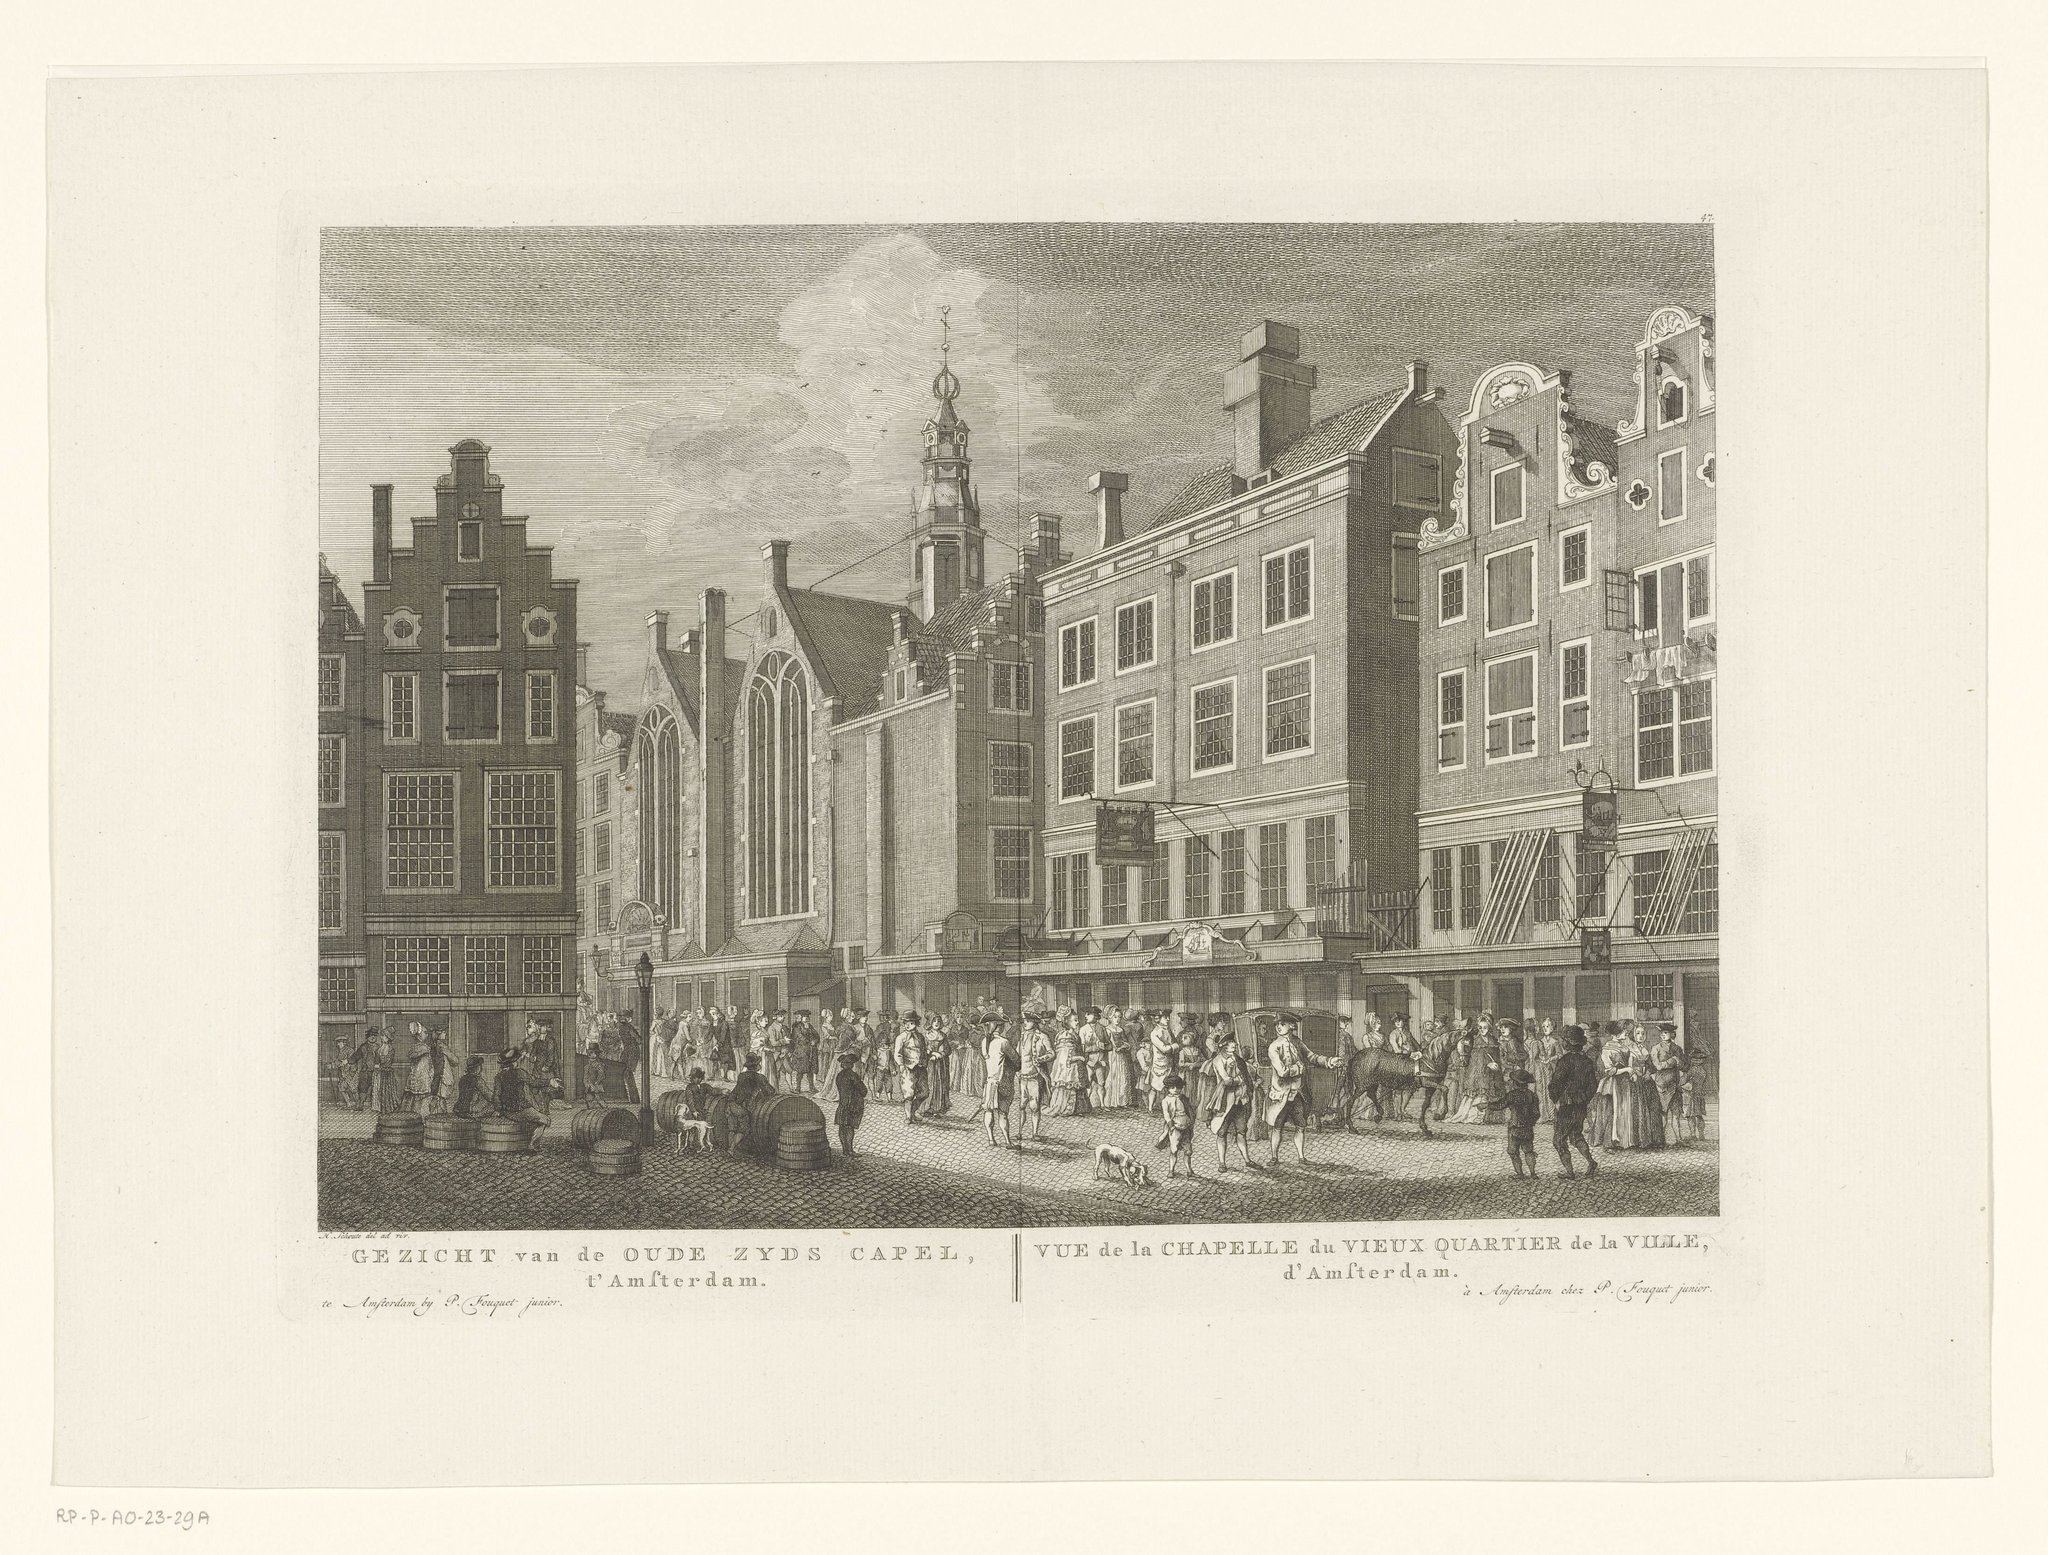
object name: print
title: Gezicht van de Oude Zyds Capel, t' Amsterdam / Vue de la Chapelle du Vieux Quartier de la Ville, d' Amsterdam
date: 1770-1783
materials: paper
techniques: engraving, etching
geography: amsterdam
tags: church (exterior) - qq - small church, chapel, street (+ city(-scape) with figures, staffage)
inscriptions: collector's mark: Lugt 2228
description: Deze prent is ook gebruikt in de zogenaamde Atlas van Fouquet.* Pierre Fouquet gaf vanaf 1760 stadsgezichten van Amsterdam - naar tekeningen van verschillende kunstenaars, gemaakt door verschillende prentmakers - uit. Deze prenten werden aanvankelijk los of in series verkocht. Zoals toen gebruikelijk kon de koper de prenten zelf laten inbinden. Hiertoe gaf Fouquet tussen 1778 en 1783 een titelblad, plattegrond en inhoudsopgave van de tot dusver 100 uitgegeven prenten uit (1). Gezien de inhoud afhankelijk was van wat de koper had verzameld verschilt de inhoud van de verschillende bewaarde Fouquetatlassen onder deze titel sterk. Ook zijn er exemplaren bekend waar tevens andere prenten aan zijn toegevoegd. Omdat er behoefte bleek aan uitleg bij de platen werd in 1783 een nieuwe versie van de atlas uitgegeven, aangevuld met tekst en twee prenten. De aangegeven volgorde veranderde maar de platen van de al eerder uitgegeven prenten bleven ongewijzigd. Deze uitgave werd in opdracht van Fouquet gedrukt bij Daniël Jean Changuion en Petrus den Hengst (2). Een tiental platen werd bijgewerkt en verscheen, met nieuw impressum, in het vervolg van Wagenaars geschiedenis van Amsterdam, uitgeven door Petrus Conradi en Folkert van der Plaats (3). Een aantal jaar na het overlijden van Fouquet kwam Evert Maaskamp met een nieuwe uitgave van de atlas, met verbeterde tekst en toevoeging van twee prenten. Op alle platen verwijderde hij het oude en liet hij zijn eigen impressum zetten (4). De huidige staat van de prent komt voor in exemplaren van de onder (1) en (2) genoemde werken. * Onder de Atlas van Fouquet of Fouquetatlas verstaan we de hieronder vermelde publicaties (1), (2) en (4). (1). Afbeeldingen van de wyd-vermaarde koopstad Amsterdam benevens des zelvs voornaamste gebouwen en gezigten alle naar het leeven getekend / Receuil des edifices les plus considerables et des plus belles vues, de la fameuse ville d'Amsterdam, dessinées d'après nature. Amsterdam: Pierre Fouquet, 1778-1783. (2). Nieuwe atlas, van de voornaamste gebouwen en gezigten der stad Amsterdam, met derzelver beknopte beschryvingen. 2 delen. Amsterdam: Daniël Jean Changuion en Petrus den Hengst [in opdracht van Pierre Fouquet], 1783. (3). Stijl, Simon. Amsterdam, in zyne geschiedenissen, voorregten, koophandel, gebouwen, kerkenstaat, schoolen, schutterye, gilden en regeeringe, beschreeven. Om te dienen ten vervolge op het werk van Jan Wagenaar (…). 10 delen. Amsterdam en Harlingen: Petrus Conradi en Folkert van der Plaats, 1788-1801. (4). Nieuwe atlas, van de voornaamste gebouwen en gezigten der stad Amsterdam. Met derzelver beknopte beschryvingen. Amsterdam: Evert Maaskamp, 1805. * Het aantal vermelde staten is gebaseerd op het aantal gevonden staten. Mogelijk zijn er meer staten van deze prent.